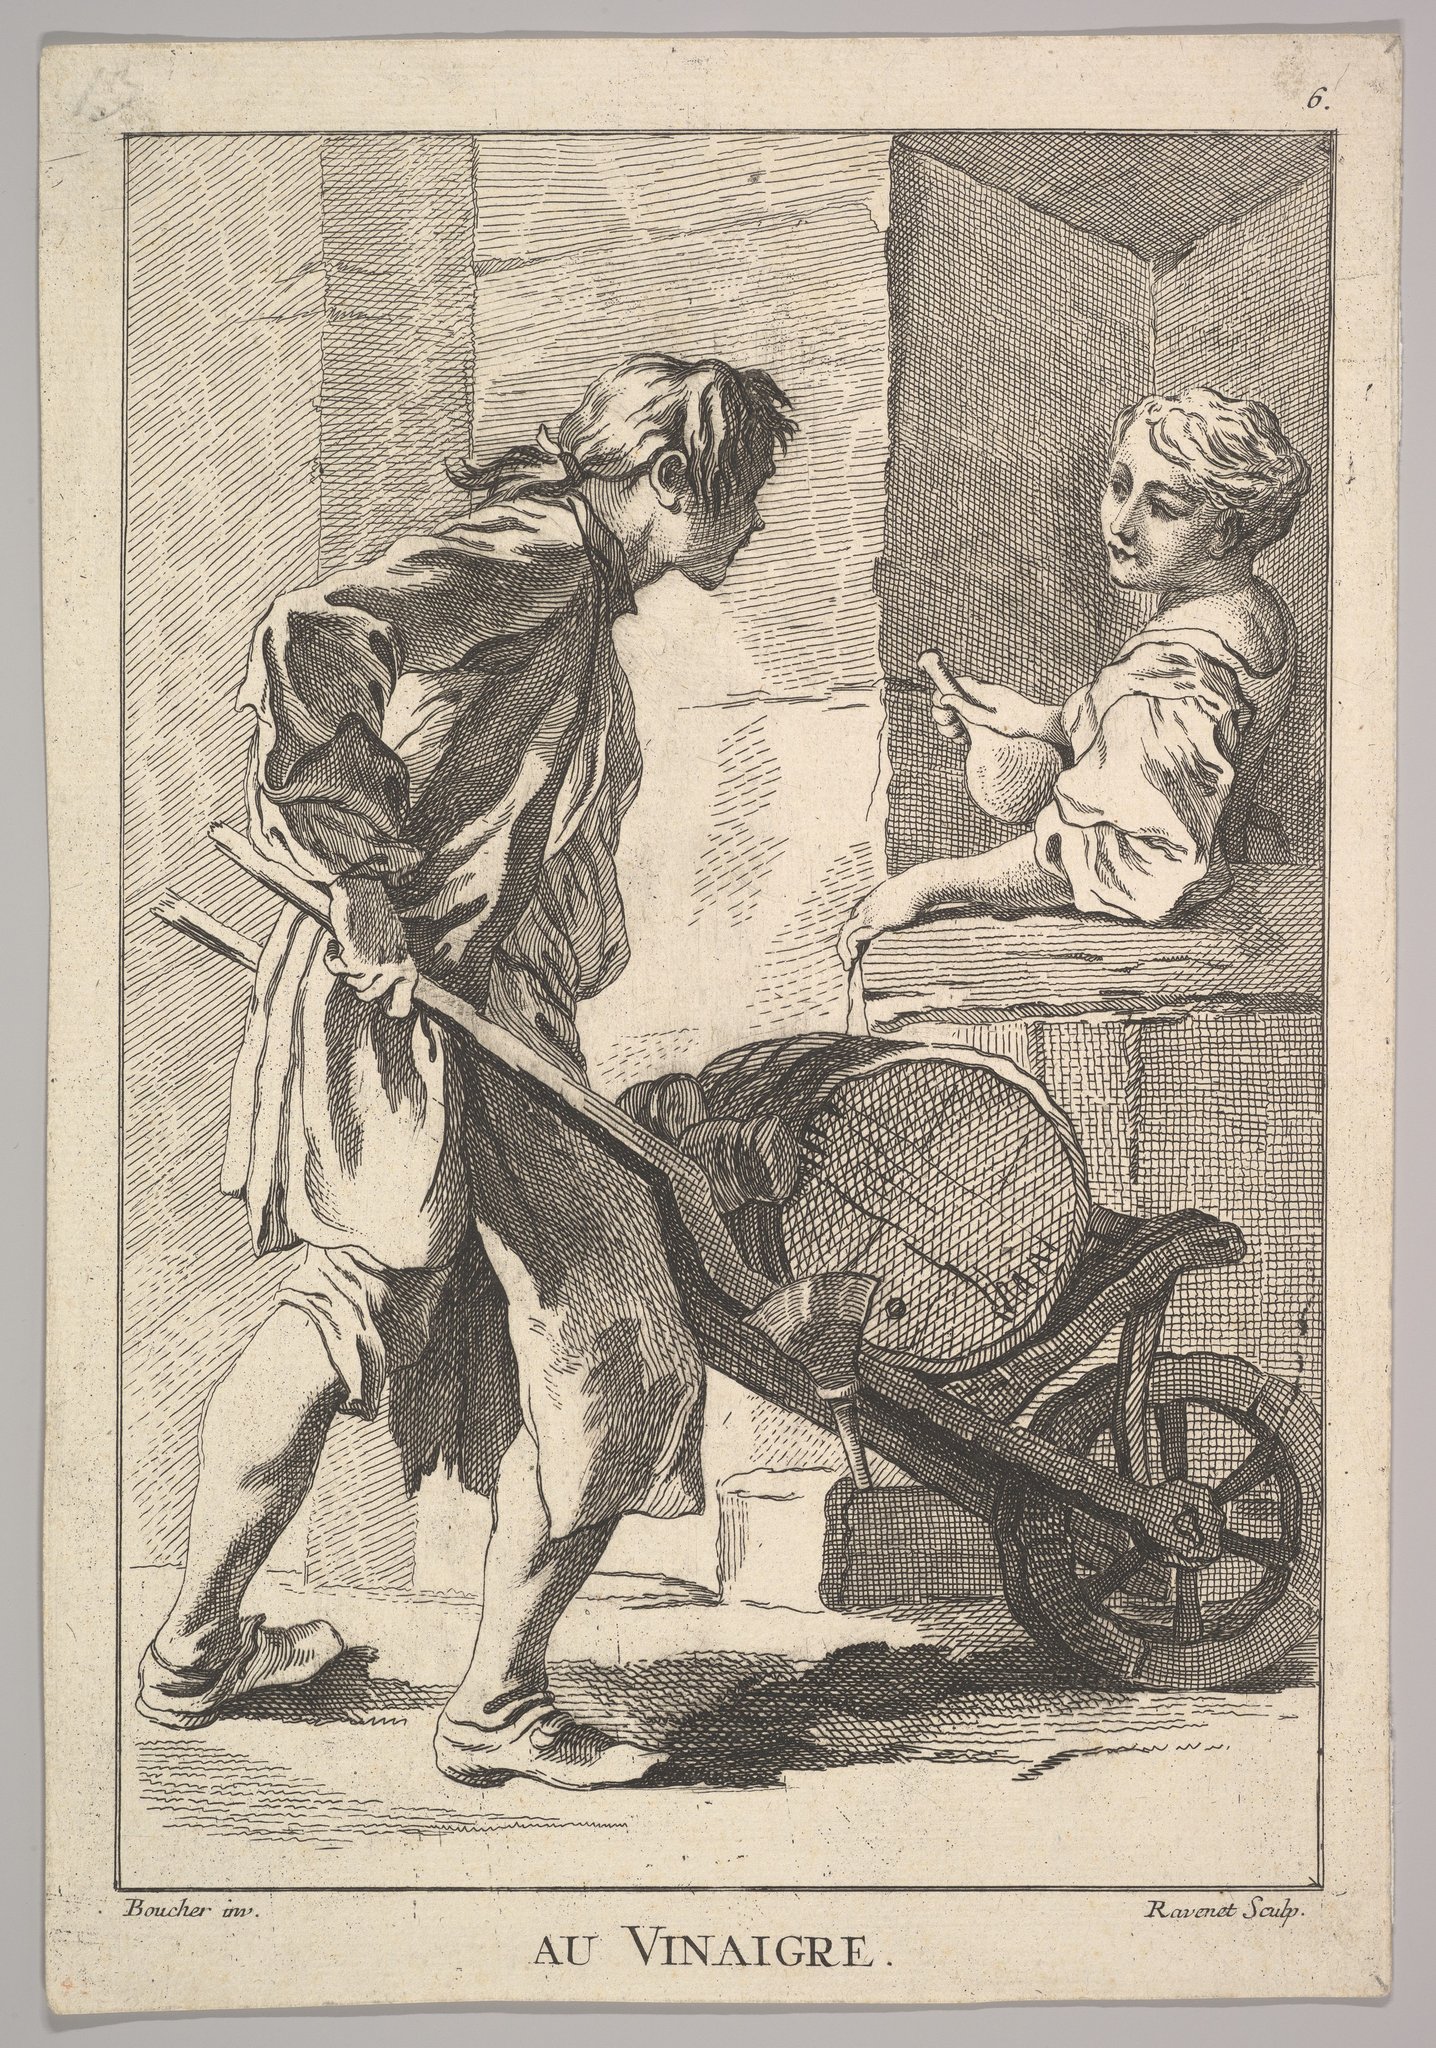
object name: print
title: Reverse copy of Au Vinaigre (Vinegar), plate 6 from "Le Cris de Paris" (The Cries of Paris)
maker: simon francis ravenet, the elder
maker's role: artist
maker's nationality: french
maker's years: 1706-1774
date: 1701-1800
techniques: engraving, etching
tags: men,women,working